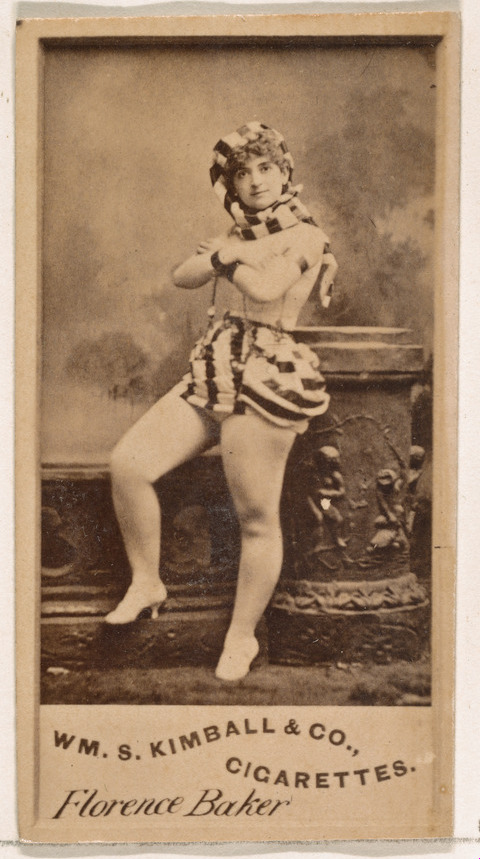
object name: photograph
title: Florence Baker, from the Actresses series (N203) issued by Wm. S. Kimball & Co.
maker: william s. kimball & company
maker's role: publisher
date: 1889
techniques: color lithograph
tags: portraits,women,actresses